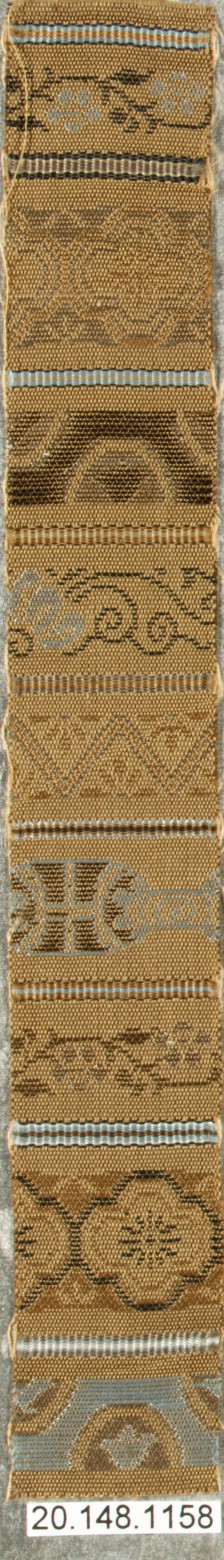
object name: piece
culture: japanese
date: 1801-1900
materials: silk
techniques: compound weave